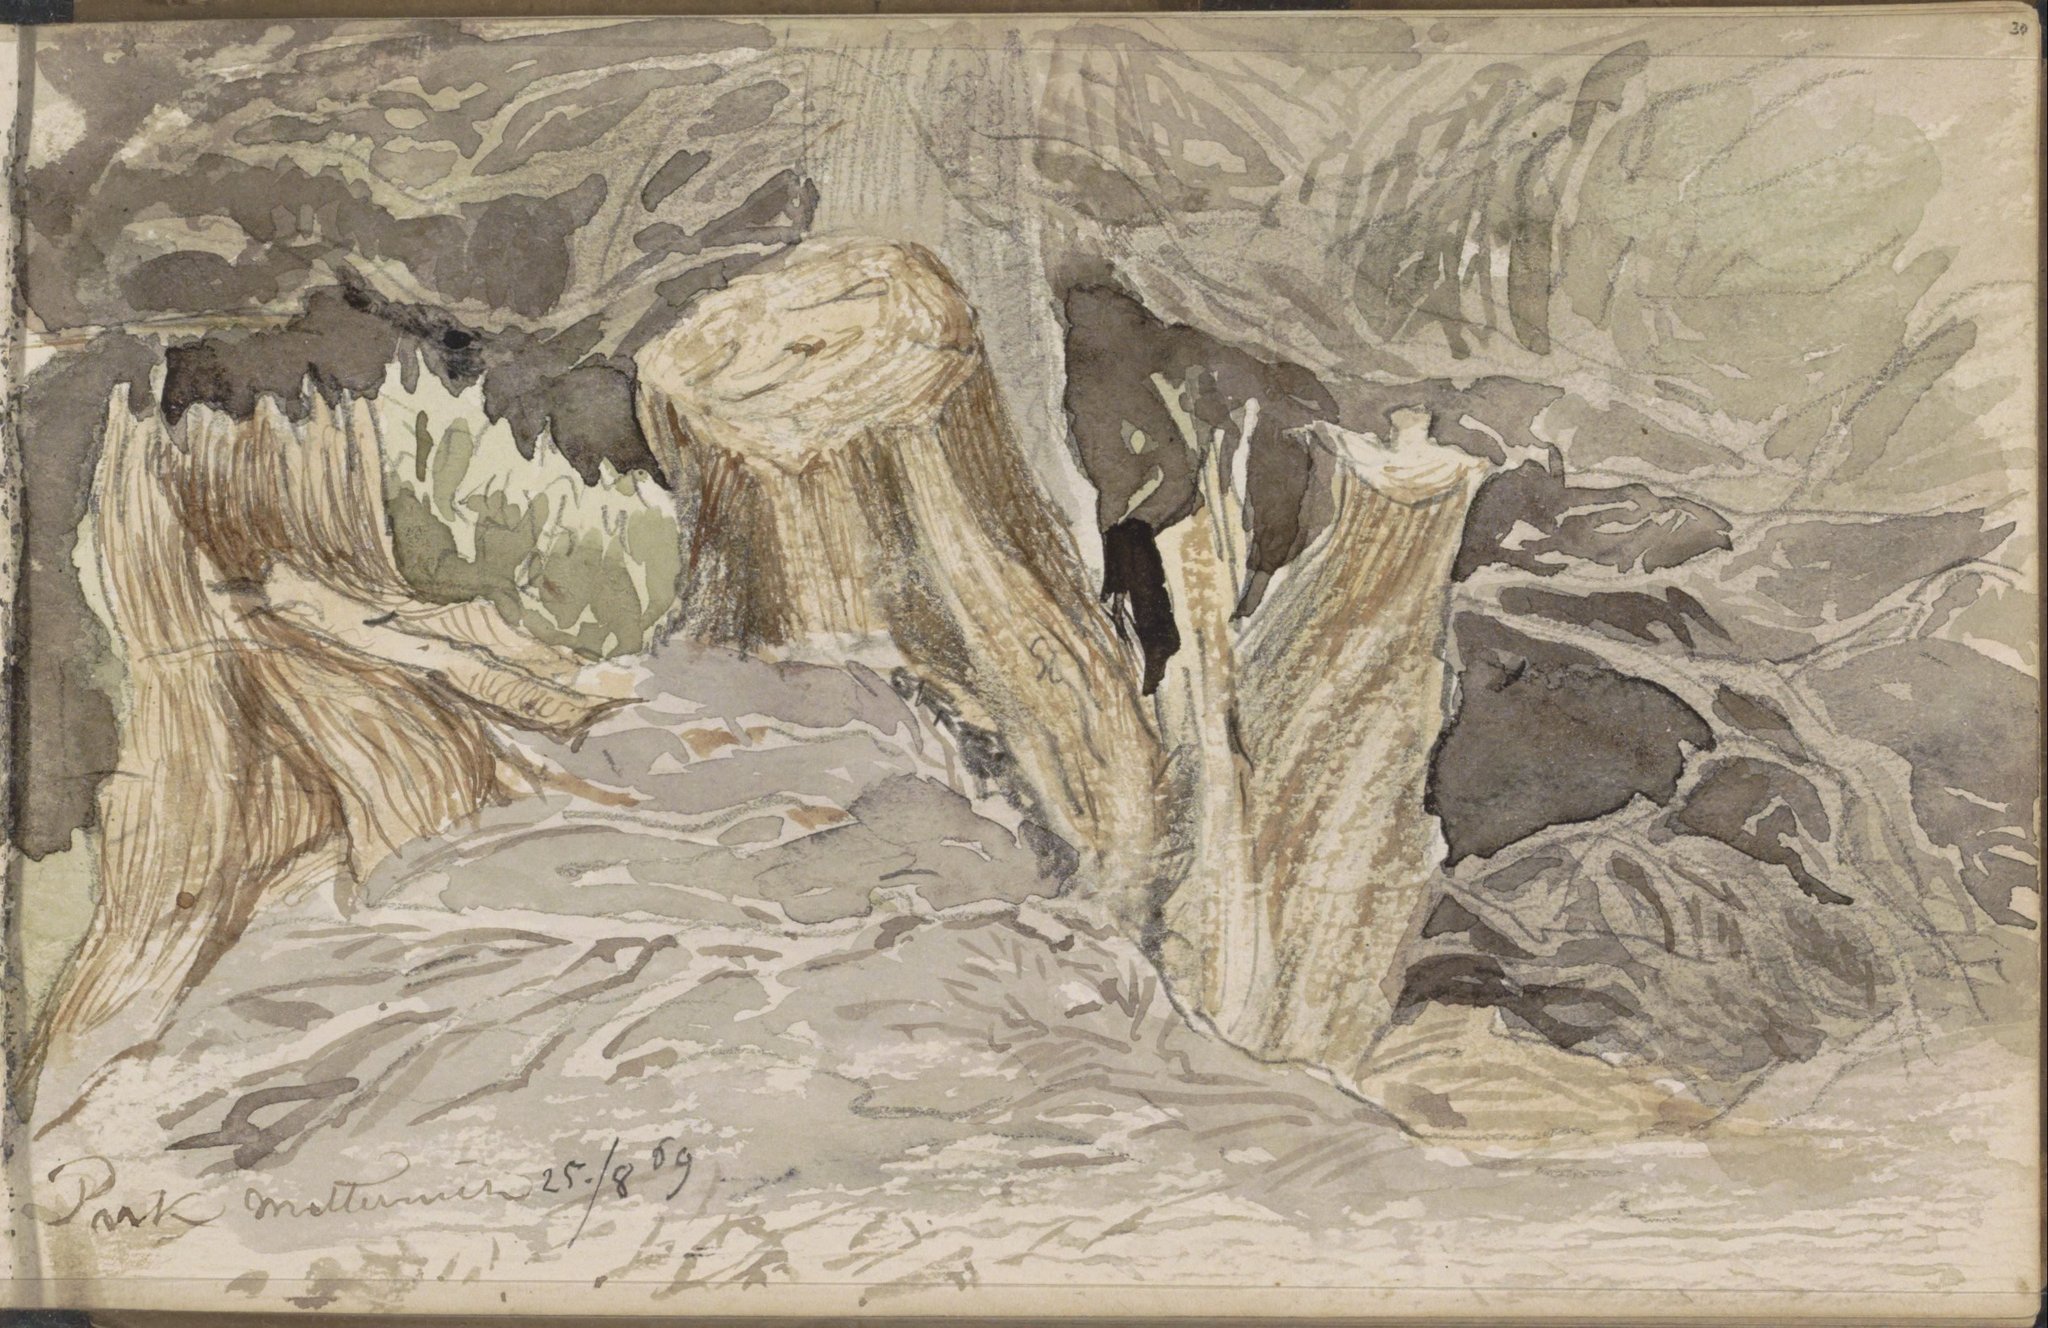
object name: sketchbook leaf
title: Gespleten boomstammen in het park van Metternich bij Marienbad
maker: johannes tavenraat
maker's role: draughtsman, painter, print maker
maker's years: 1809-1881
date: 1808-1869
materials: ink, paper, pencil, watercolor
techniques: brush, pen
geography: marienbad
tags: forest, wood, marienbad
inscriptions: date and inscription: ‘Park Metternich 25./8 69’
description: Blad 30 recto uit een schetsboek met 48 bladen.